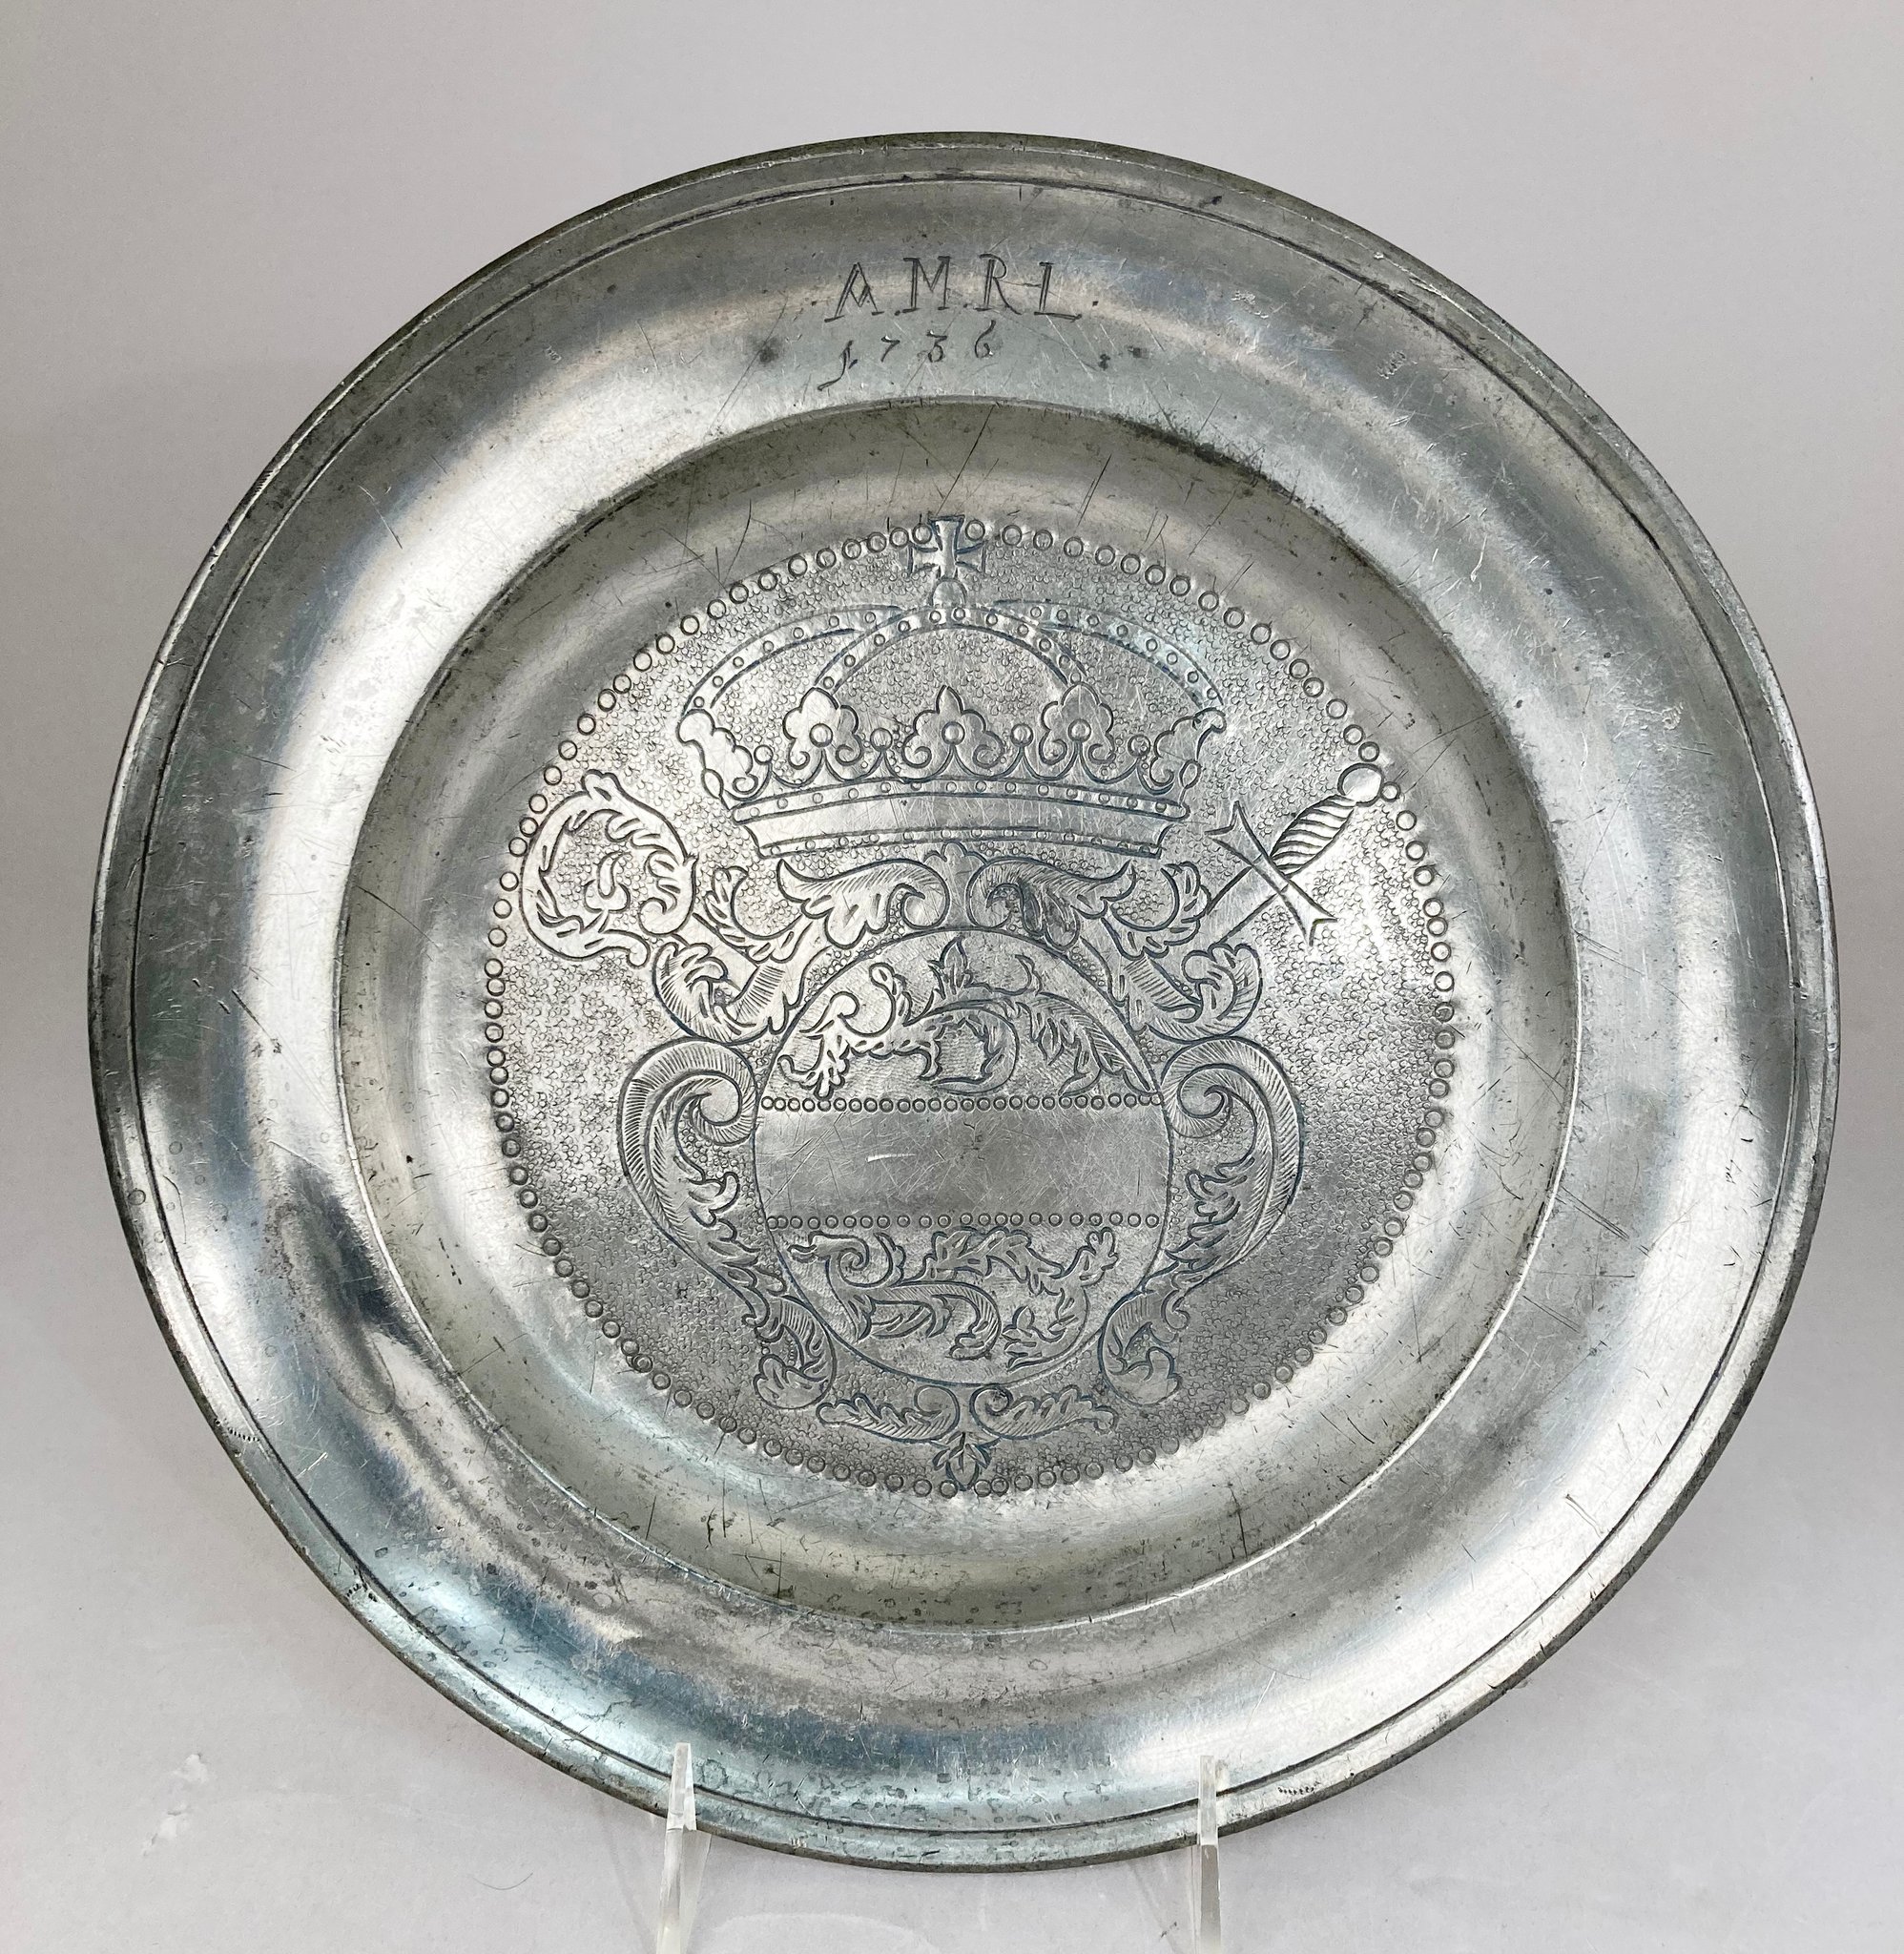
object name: plate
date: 1701-1800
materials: pewter